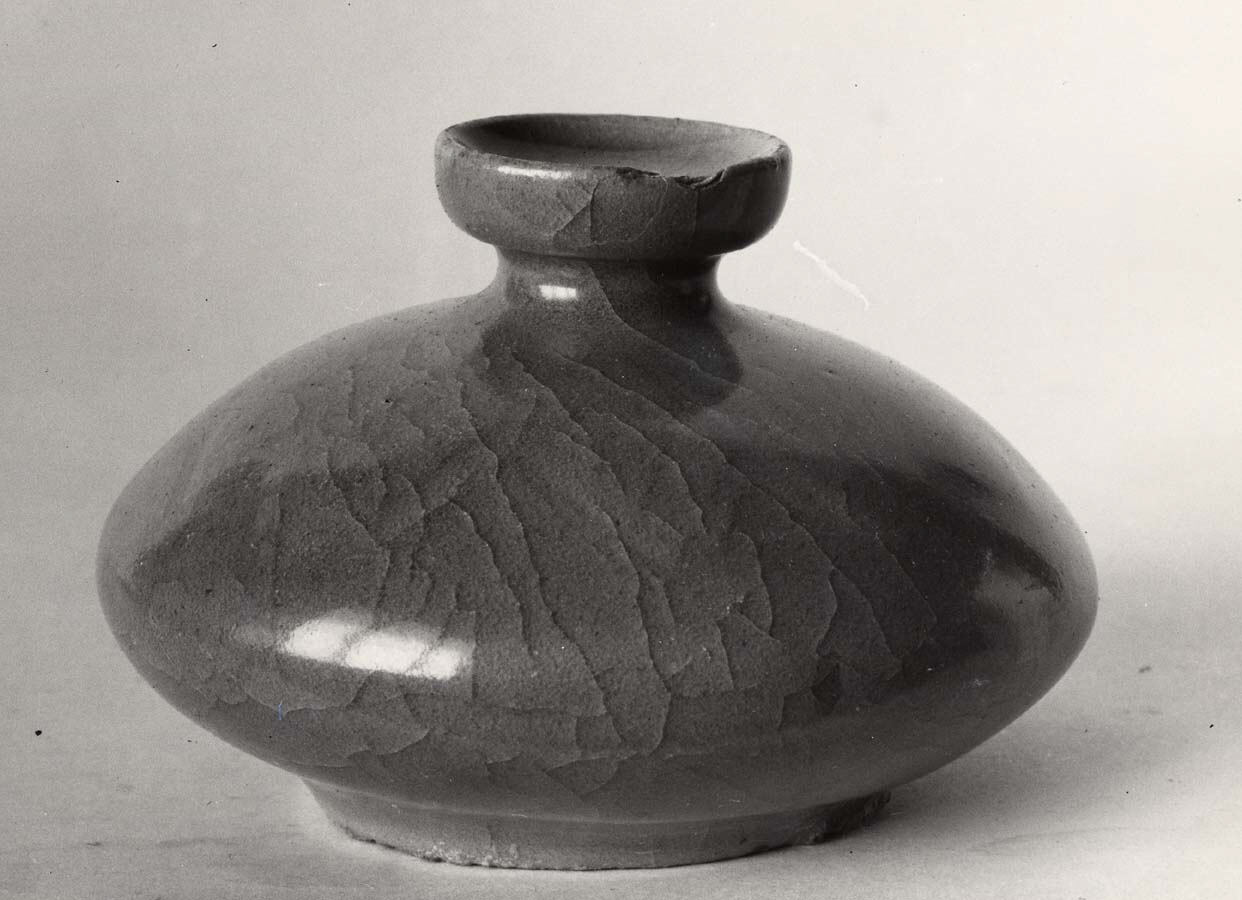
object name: bottle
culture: korean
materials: clay